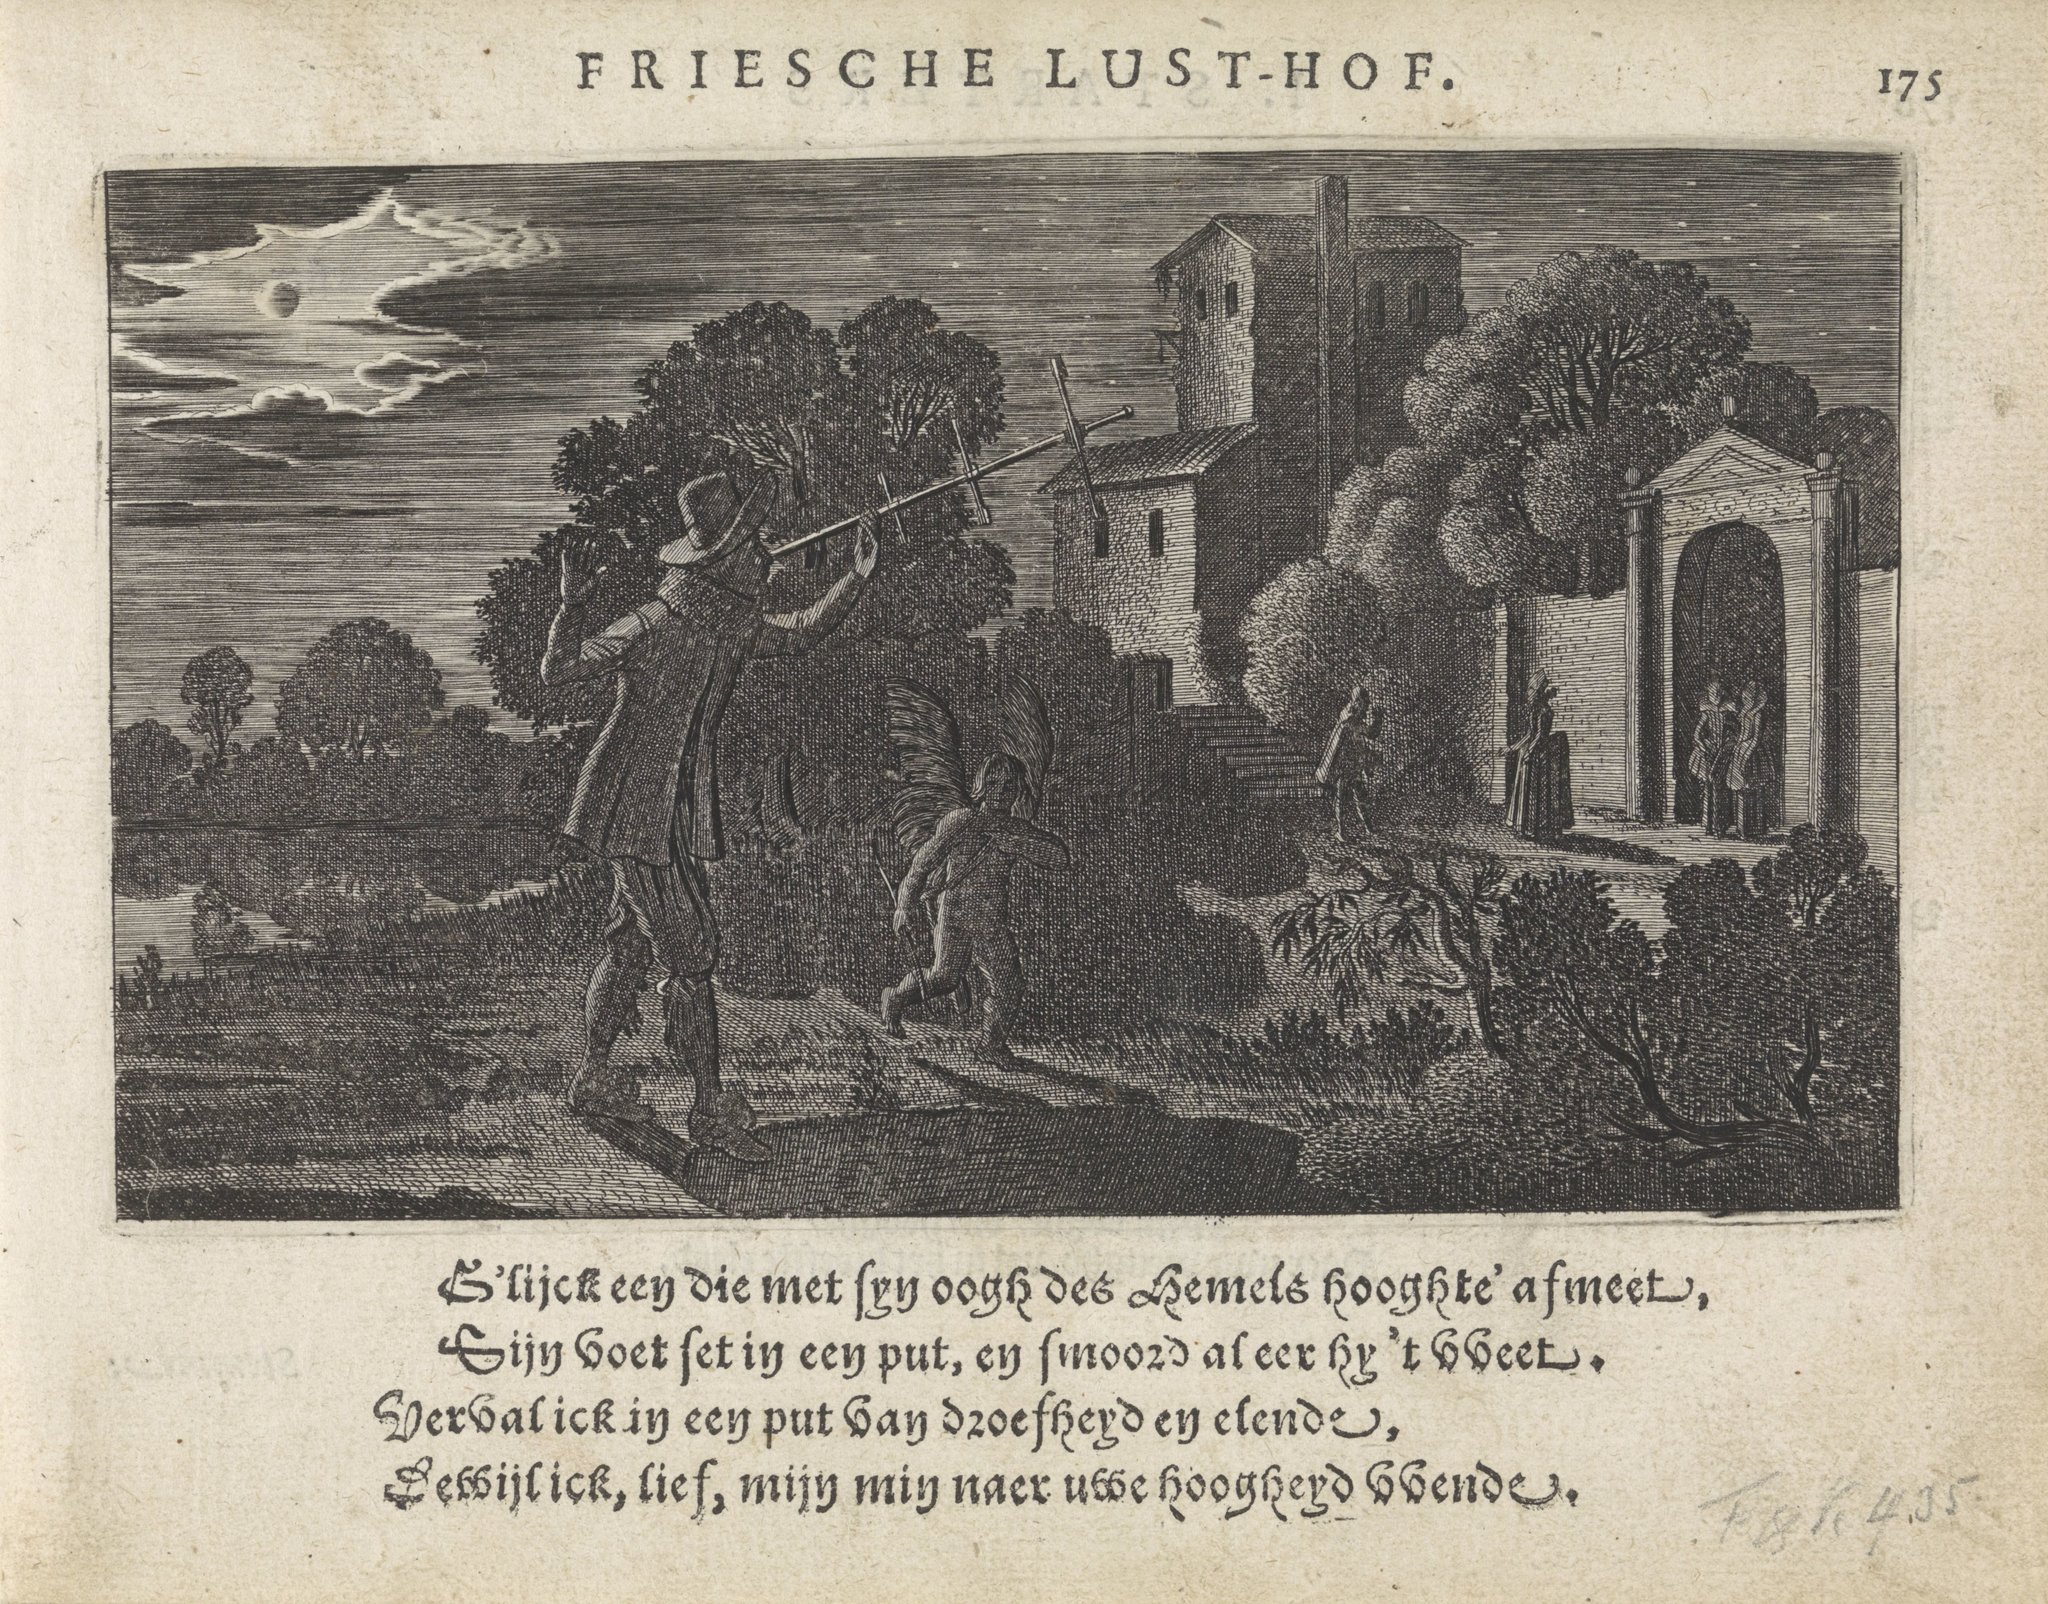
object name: print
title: Astronoom bestudeert de nachtelijke hemel en valt in een gat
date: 1621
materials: paper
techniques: etching, letterpress printing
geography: amsterdam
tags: astronomical instruments, gate, entrance, (story of) cupid, amor (eros), pit, hole, night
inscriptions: collector's mark: Lugt 964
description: Een man met een astronomisch meetinstrument in zijn hand bestuurt de hemel bij nacht en stapt met zijn voet in een gat. Naast hem Amor met pijlenkoker en boog. Op de achtergrond twee paren bij een poort en een huis. Rechtsboven genummerd: 175.